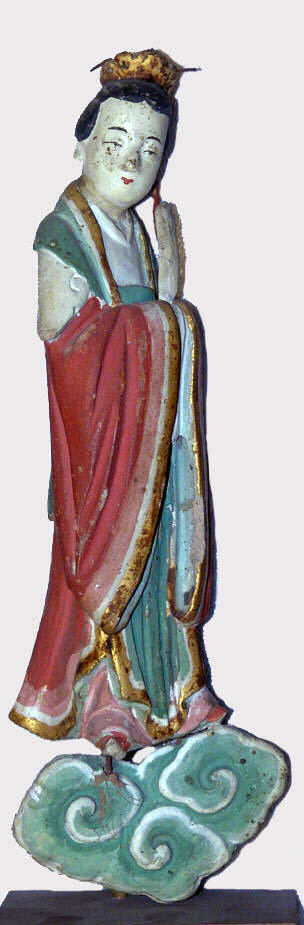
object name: statuette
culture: chinese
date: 1601-1700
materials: mud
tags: women